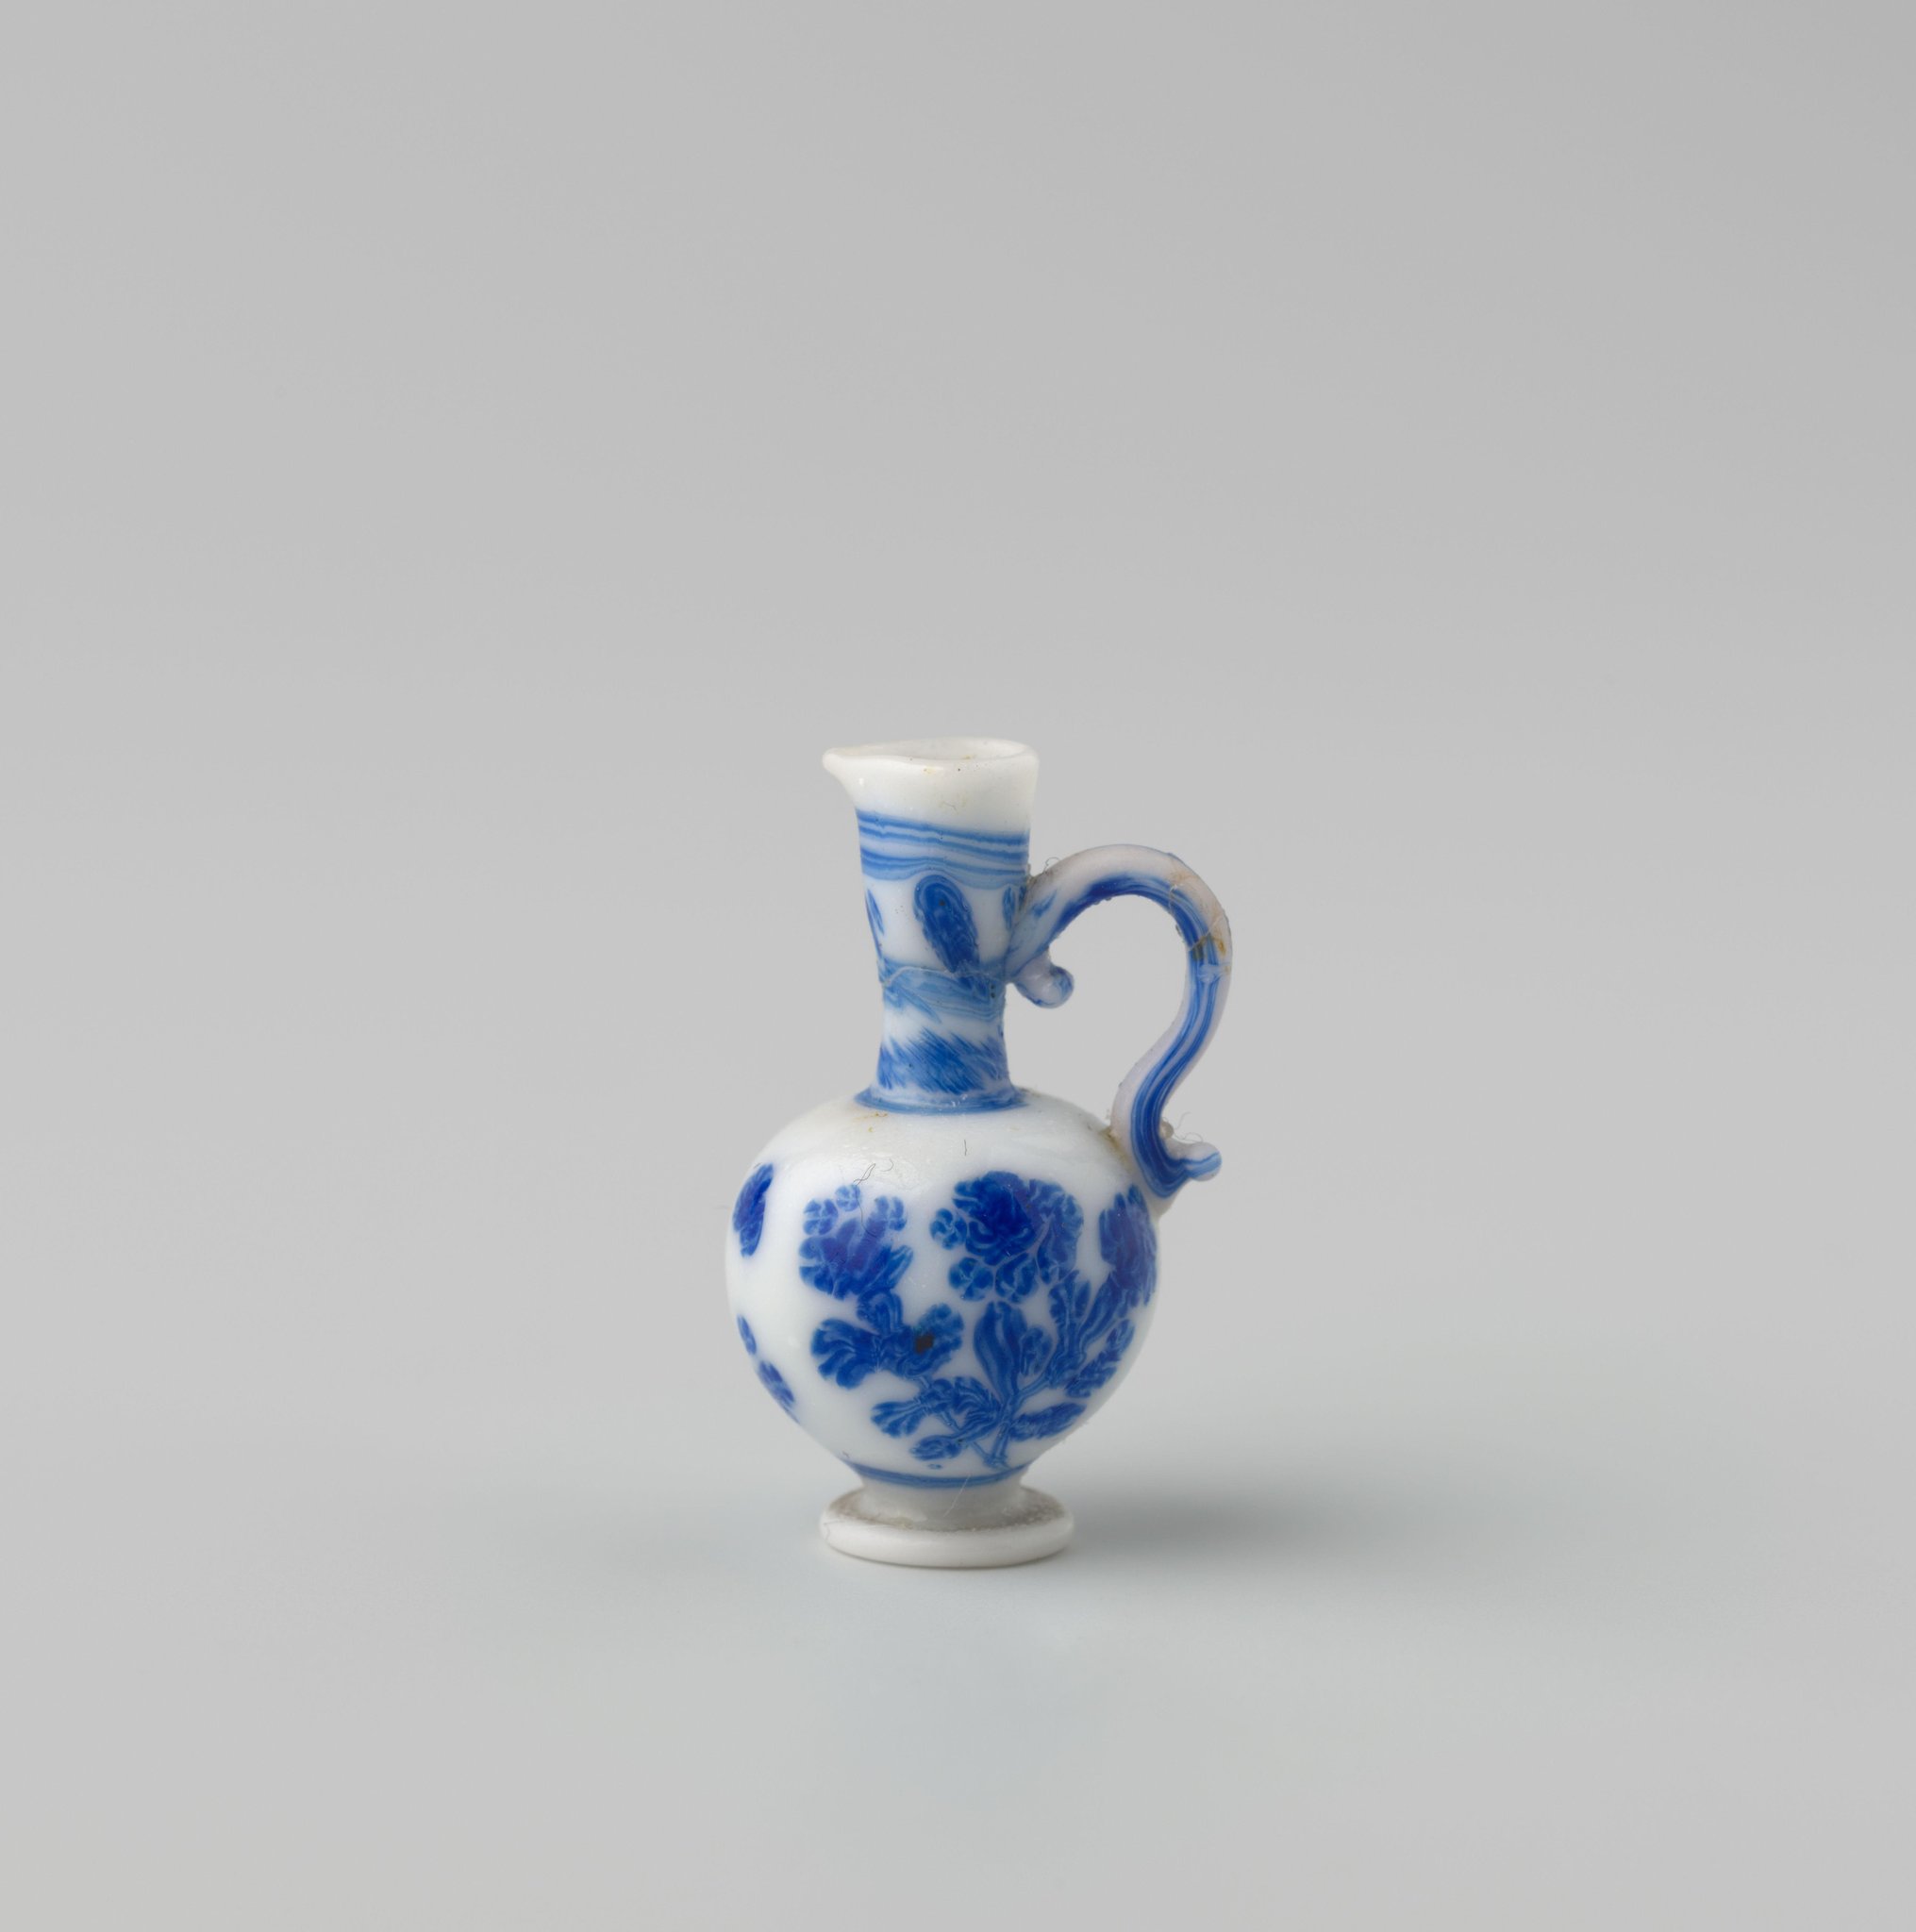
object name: ewer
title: Kan van melkglas met blauwe emailverf beschilderd, imitatie Chinees porselein; bloemtakken op buik en streepjes (?) op de hals, bolle buik, op brede voet.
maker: Anonymous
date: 1675-1710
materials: glass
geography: amsterdam